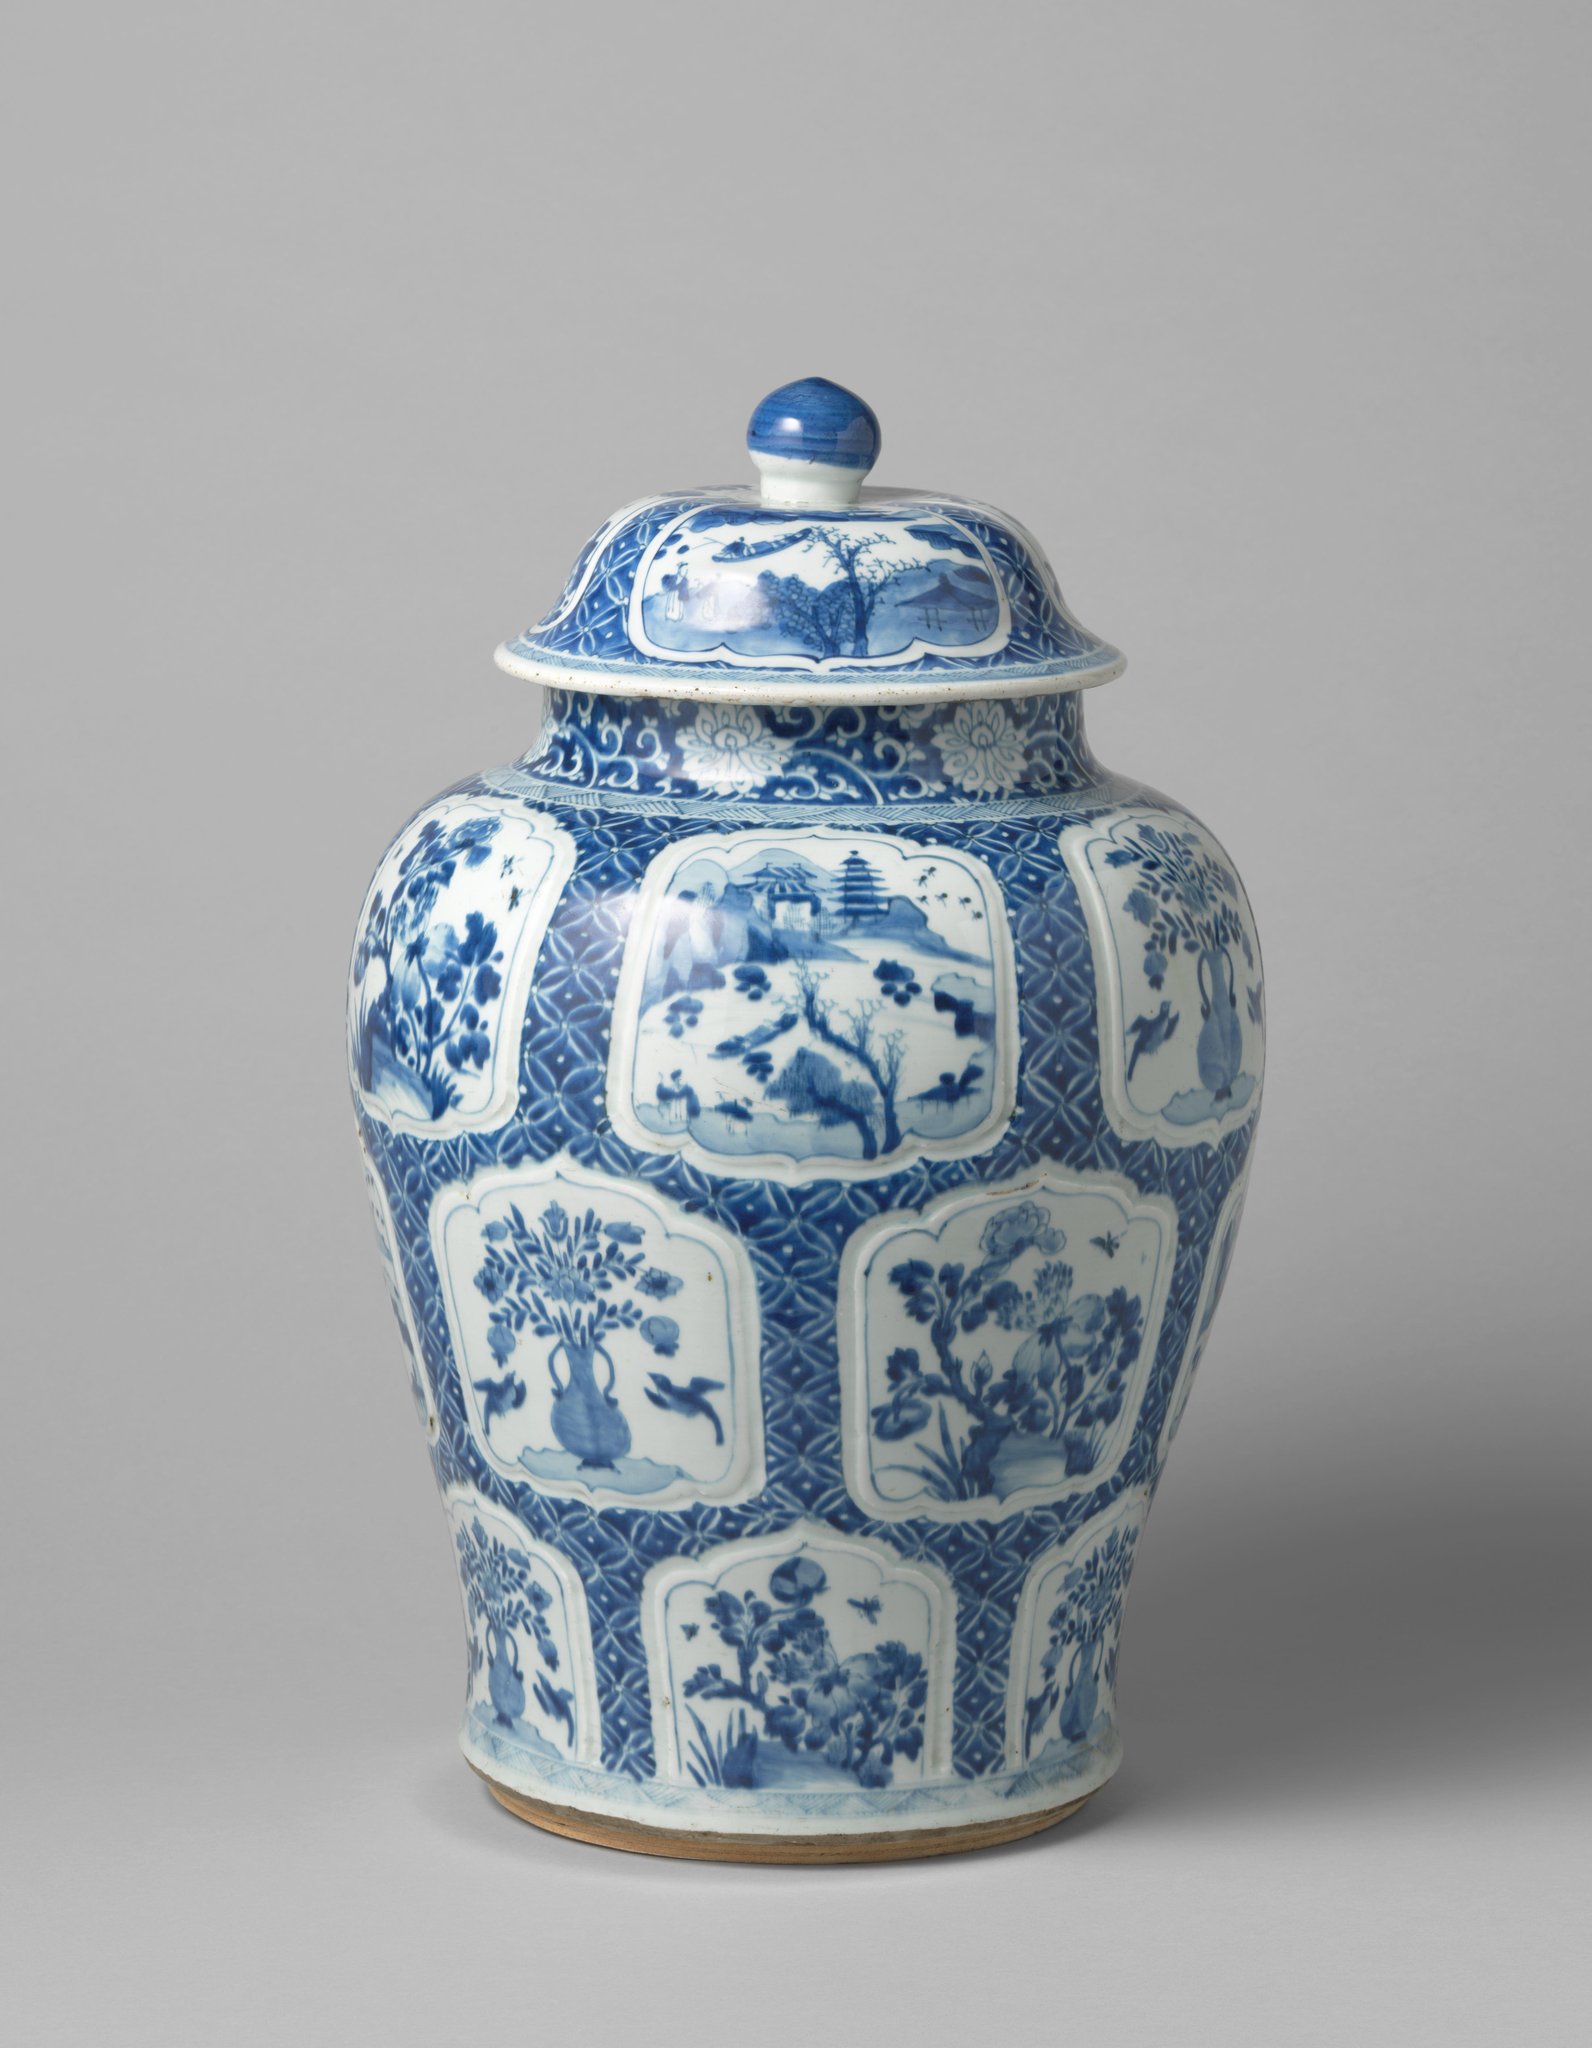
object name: pot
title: Baluster covered jar with flower vases, flowering plants and landscapes in panels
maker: Anonymous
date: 1680-1720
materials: cobalt, glaze, paint, porcelain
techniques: firing, turning, vitrification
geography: china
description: Balustervormige dekselpot van porselein, beschilderd in onderglazuur blauw. De buik is bedekt met servetwerk met daarin uitgespaard gemodelleerde, geschulpte cartouches met een bloemenvaas (lotus) met twee vogels, bloeiende planten (pioen) bij een rots of een rivierlandscap met twee persoon, een boot, paviljoens, bomen en bergen. De hals met gestileerde lotusranken. Op de schouder en rond de voet een band met arceerwerk. Blauw-wit.